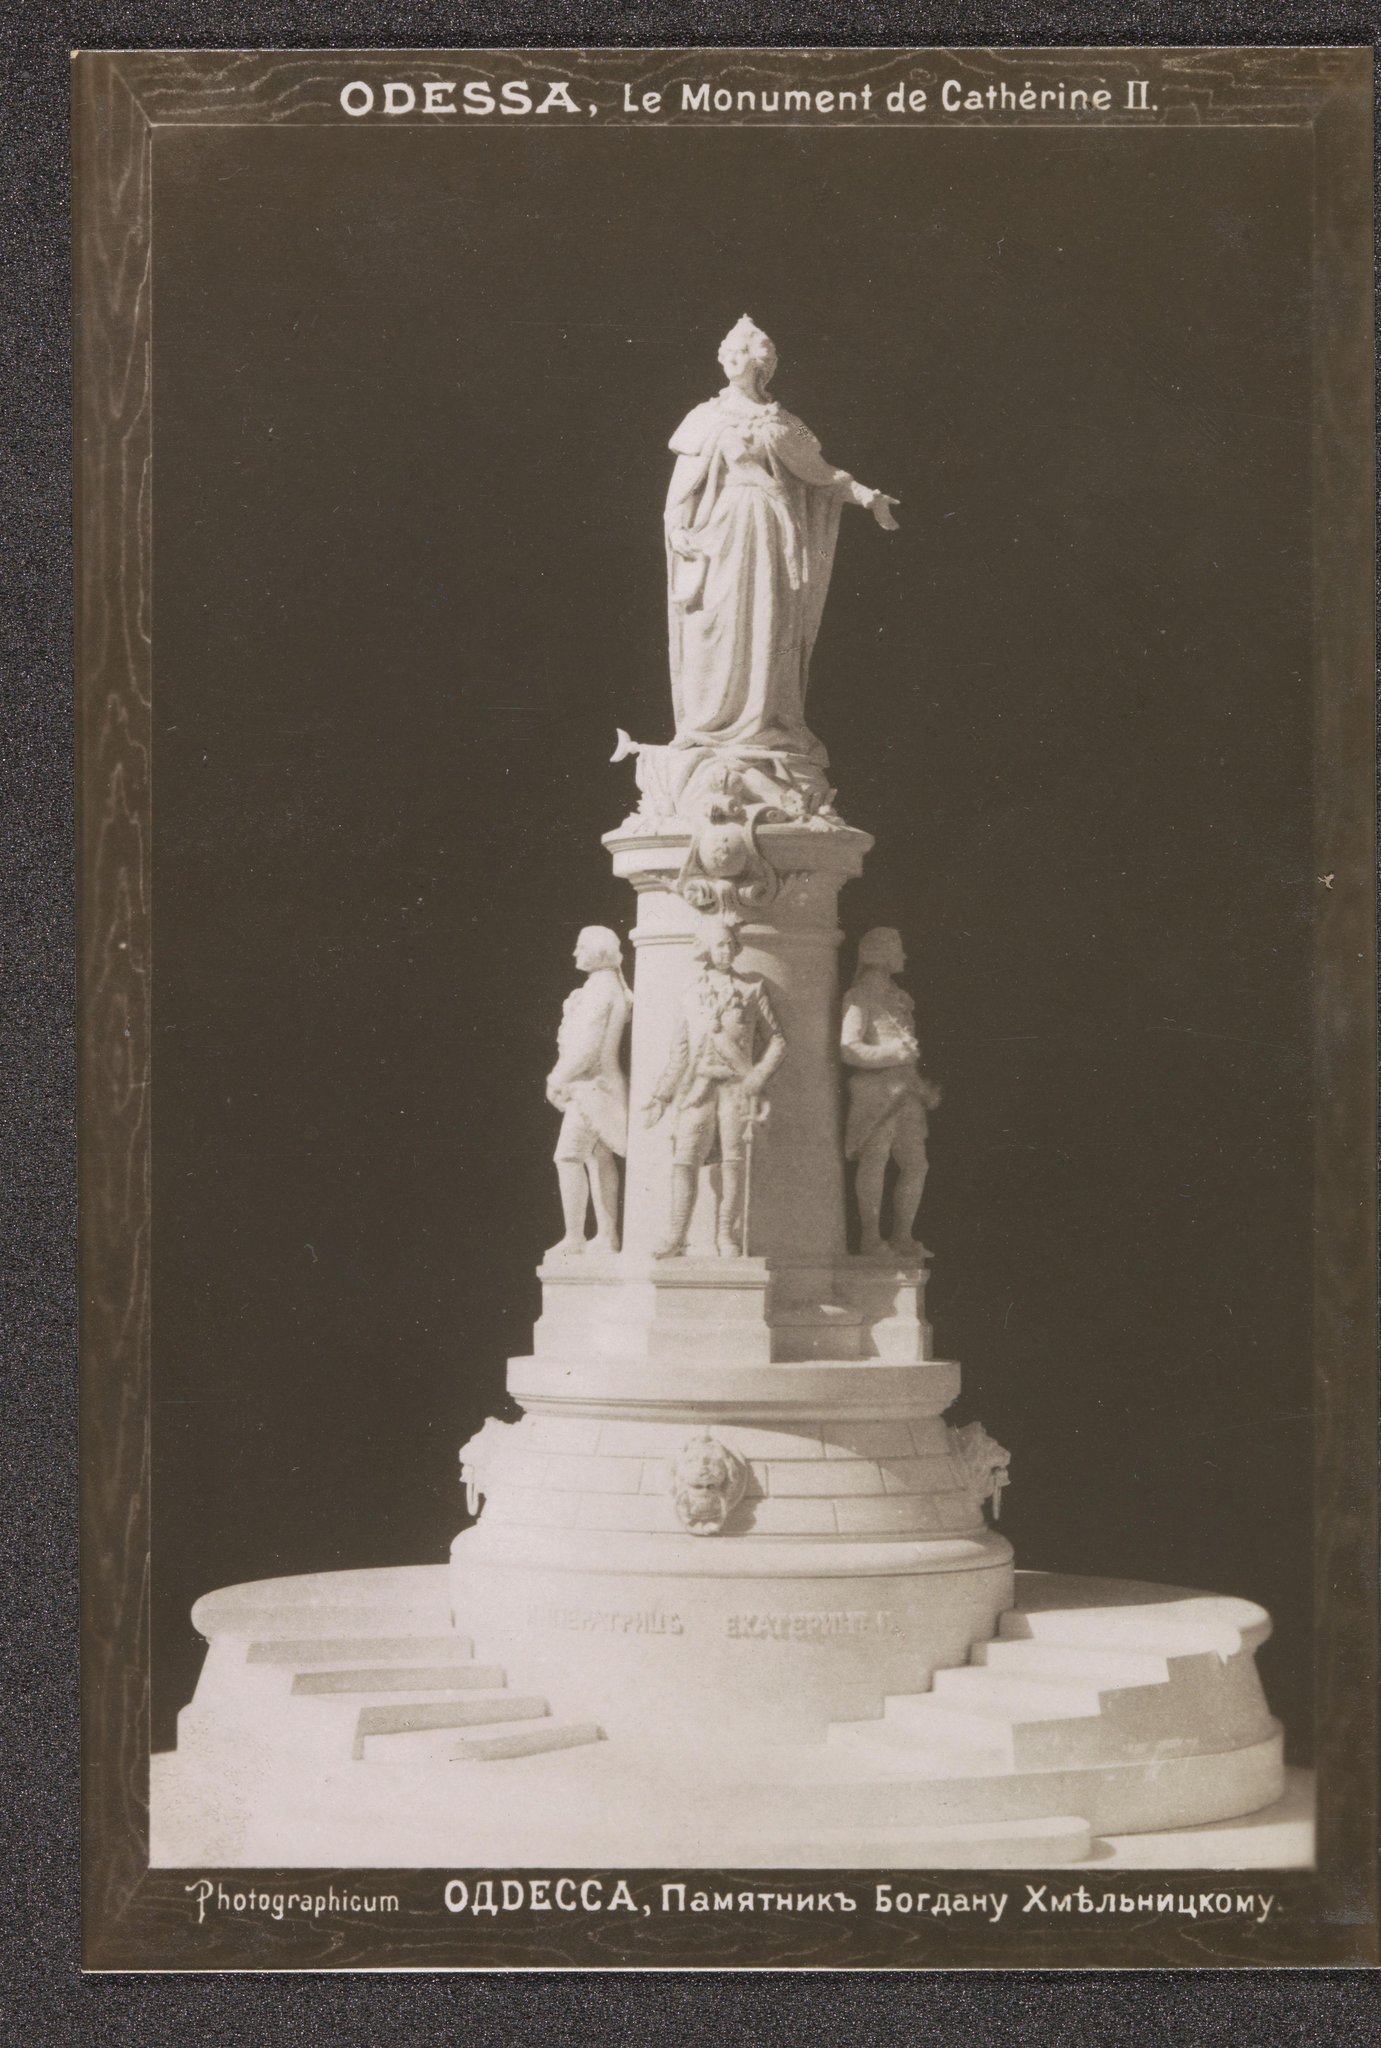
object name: photograph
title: Gipsmodel (vermoedelijk) van het standbeeld van Catharina de Grote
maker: Anonymous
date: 1900-1930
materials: photographic support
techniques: gelatin silver print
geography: odessa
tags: catharina de grote, monument, statue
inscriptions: inscription: ‘Photographicum’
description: Onderdeel van Fotoalbum met opnames van bezienswaardigheden in Odessa.